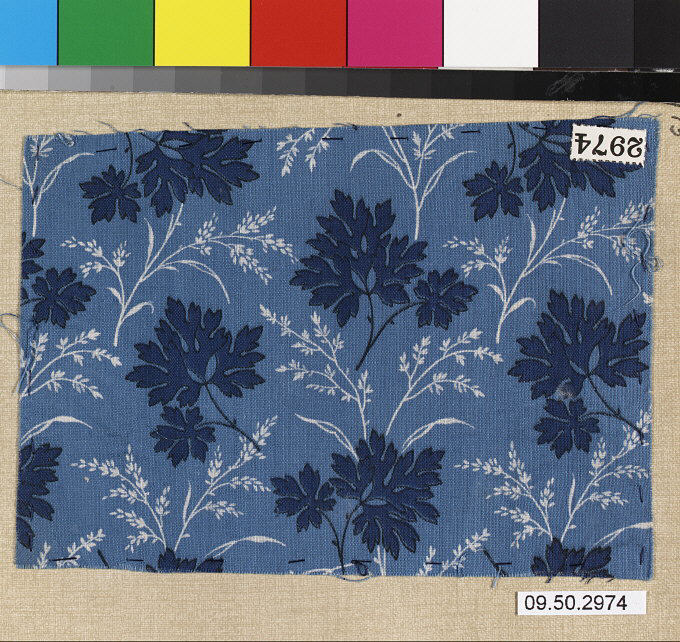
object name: piece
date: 1801-1900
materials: cotton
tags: leaves